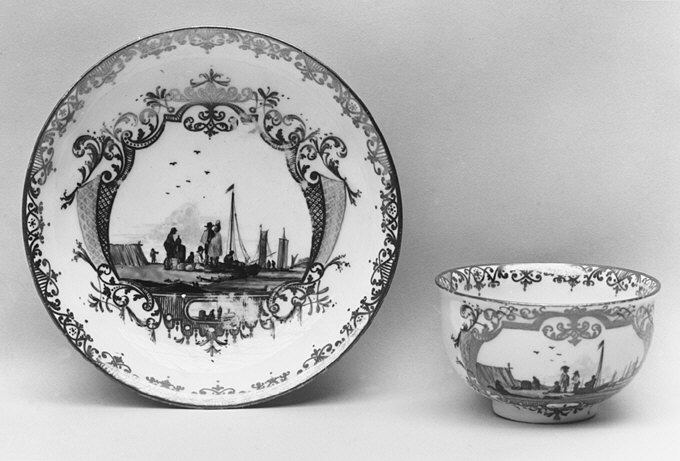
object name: saucer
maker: meissen manufactory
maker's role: manufactory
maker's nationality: german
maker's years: 1710-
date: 1730-1735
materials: hard paste porcelain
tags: human figures,birds,ships